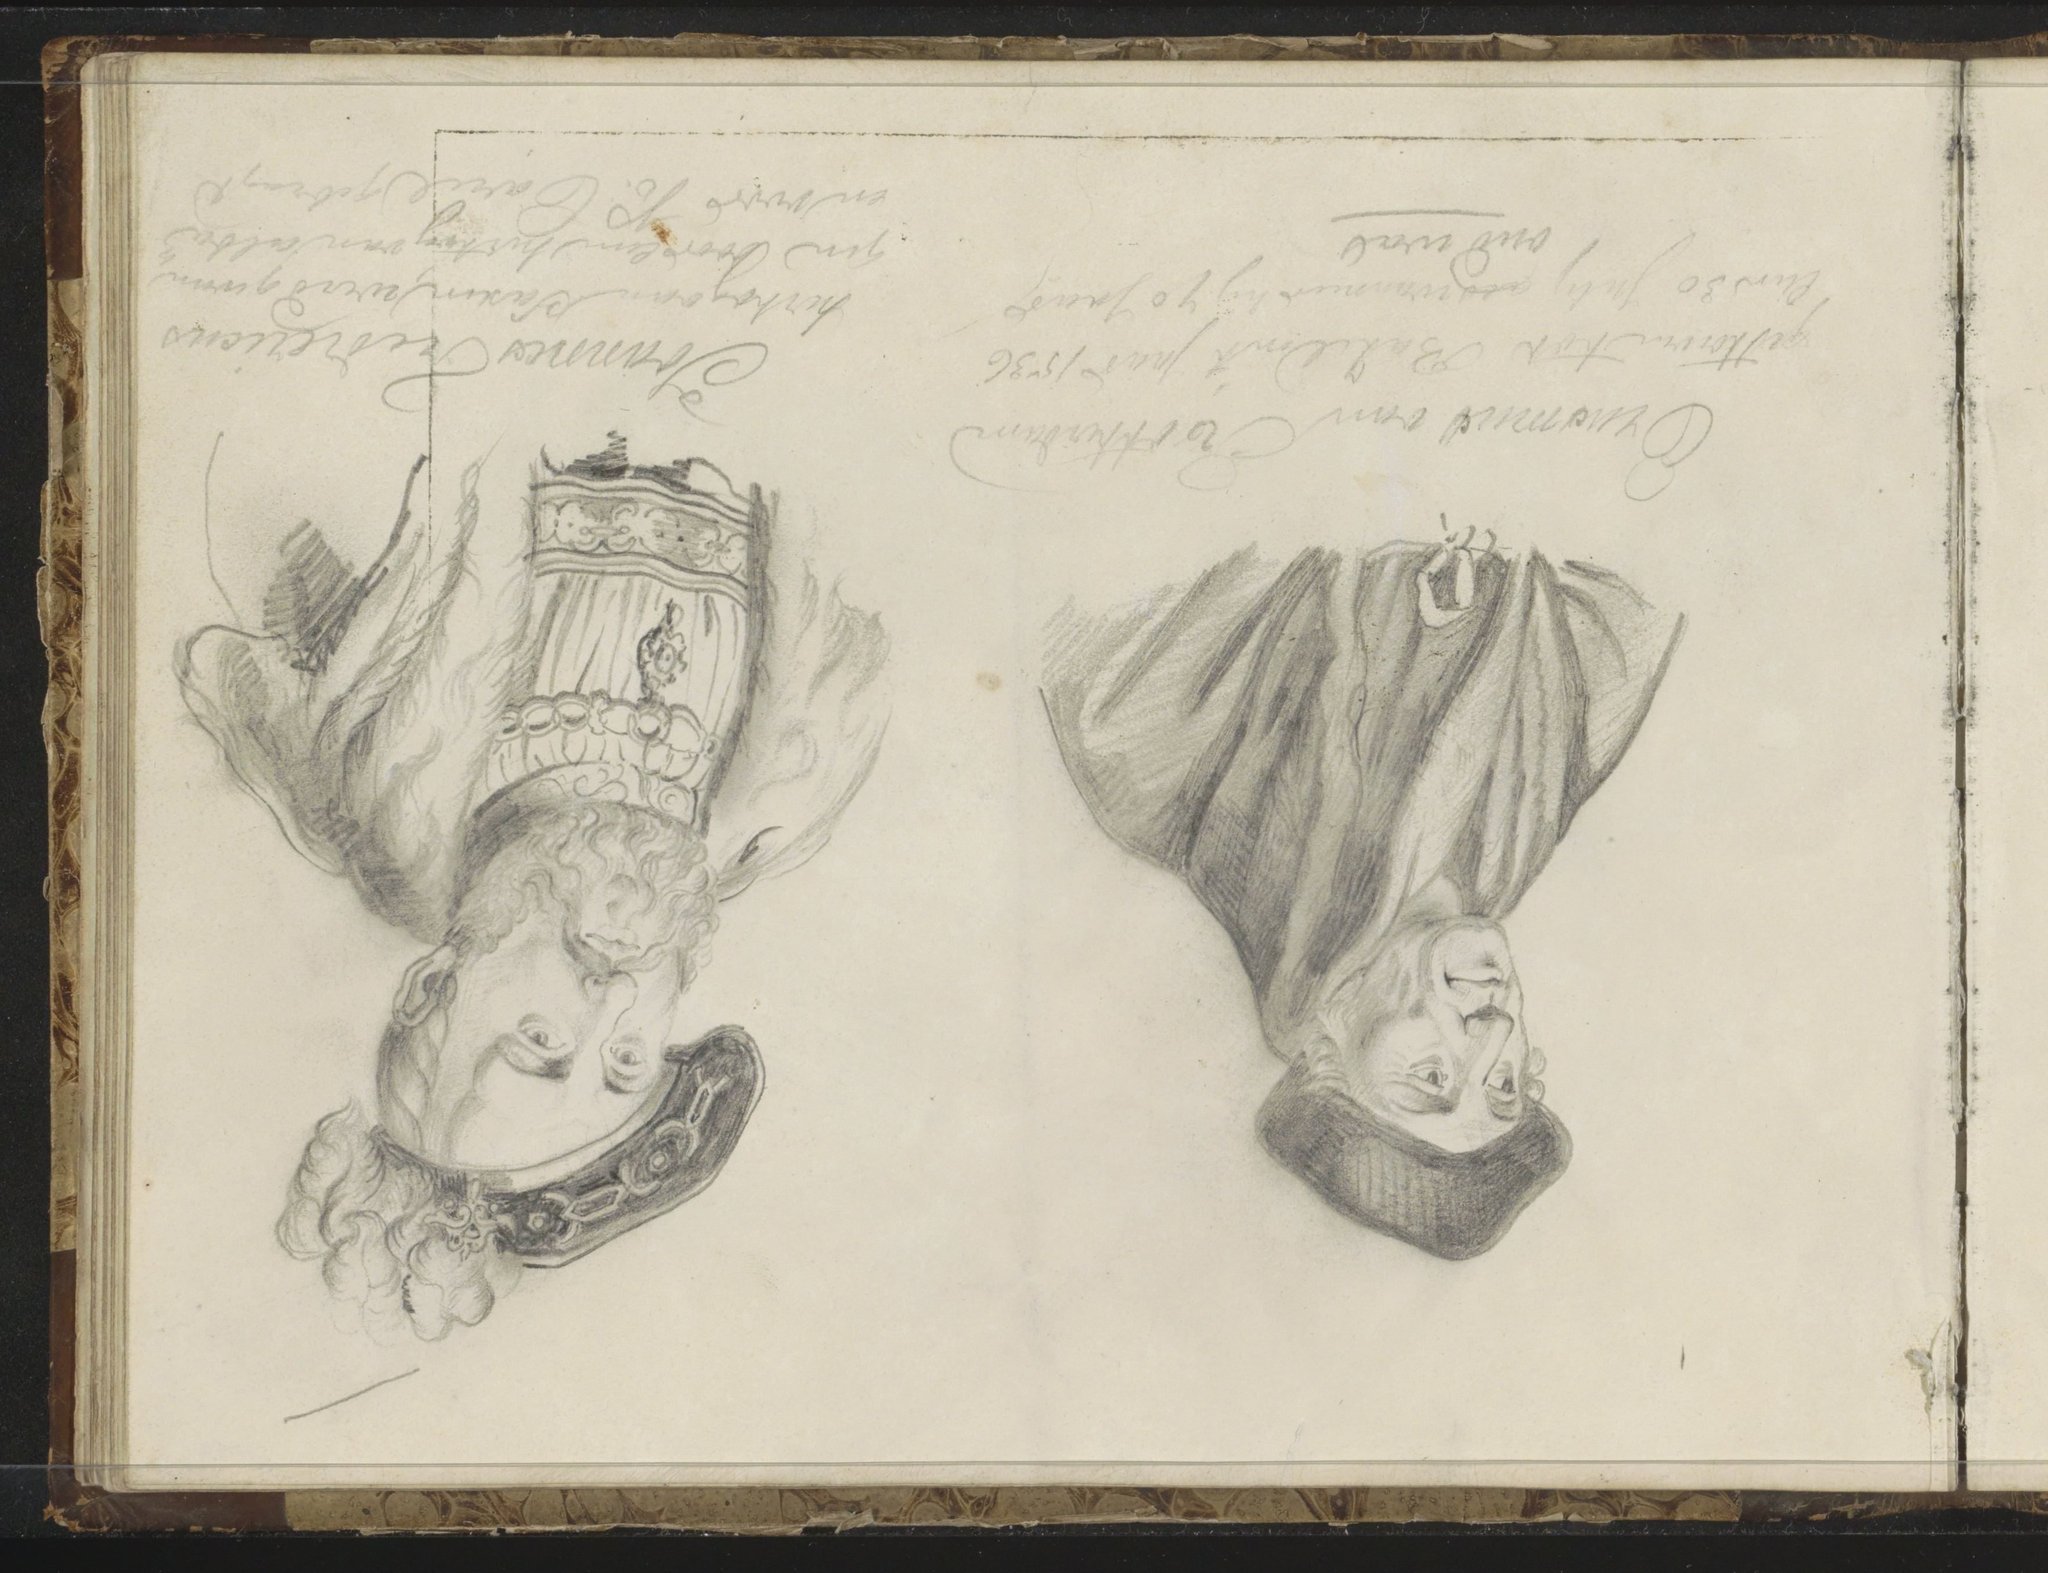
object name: sketchbook leaf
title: Portretten van Desiderius Erasmus en Johan Frederik II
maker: willem hendrik schmidt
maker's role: draughtsman, painter, print maker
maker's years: 1809-1849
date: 1819-1849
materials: paper, pencil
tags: rotterdam, desiderius erasmus, historical persons (portraits and scenes from the life)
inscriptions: annotation: ‘Erasmus van Rotterdam/ gestorven ten Bazel in 't jaar 1536/ den 30 July wanneer hij 70 Jaar/ oud was/ Johannes Fredericus/ hertog van Saksen, werd gevan/ gen door den hertog van alba/ en voor K. Carel gebragt’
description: Blad 22 verso uit een schetsboek met 52 bladen.